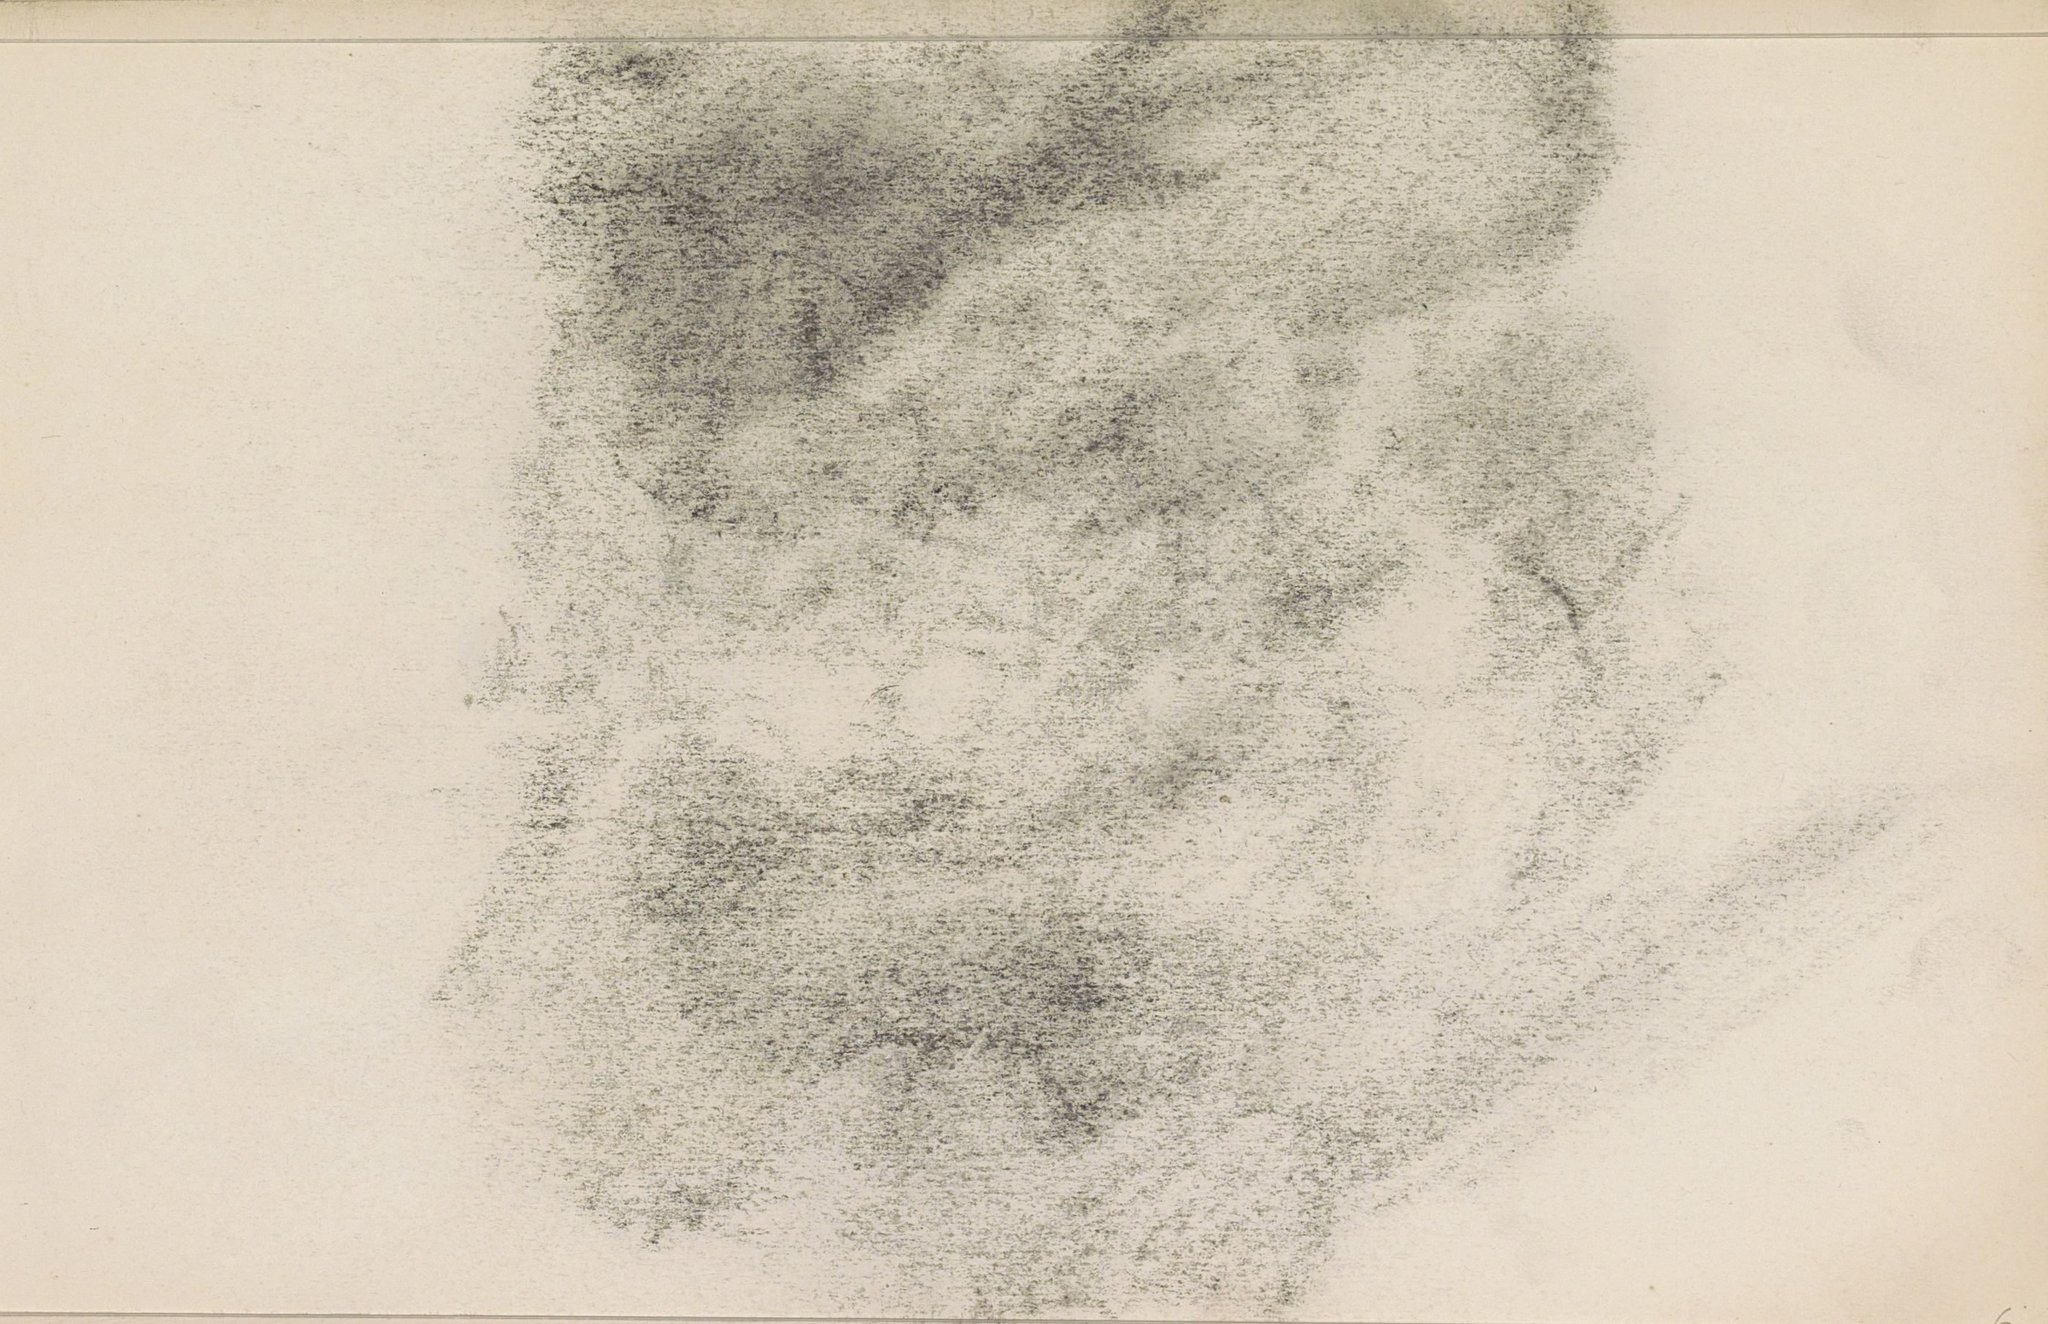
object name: sketchbook leaf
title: Abklatsch van de krijttekening op blad 5 verso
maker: isaac israels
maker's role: draughtsman, painter, print maker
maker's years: 1865-1934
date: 1875-1934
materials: paper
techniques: printmaking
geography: paris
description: Blad 6 recto uit schetsboek LI met 11 bladen.